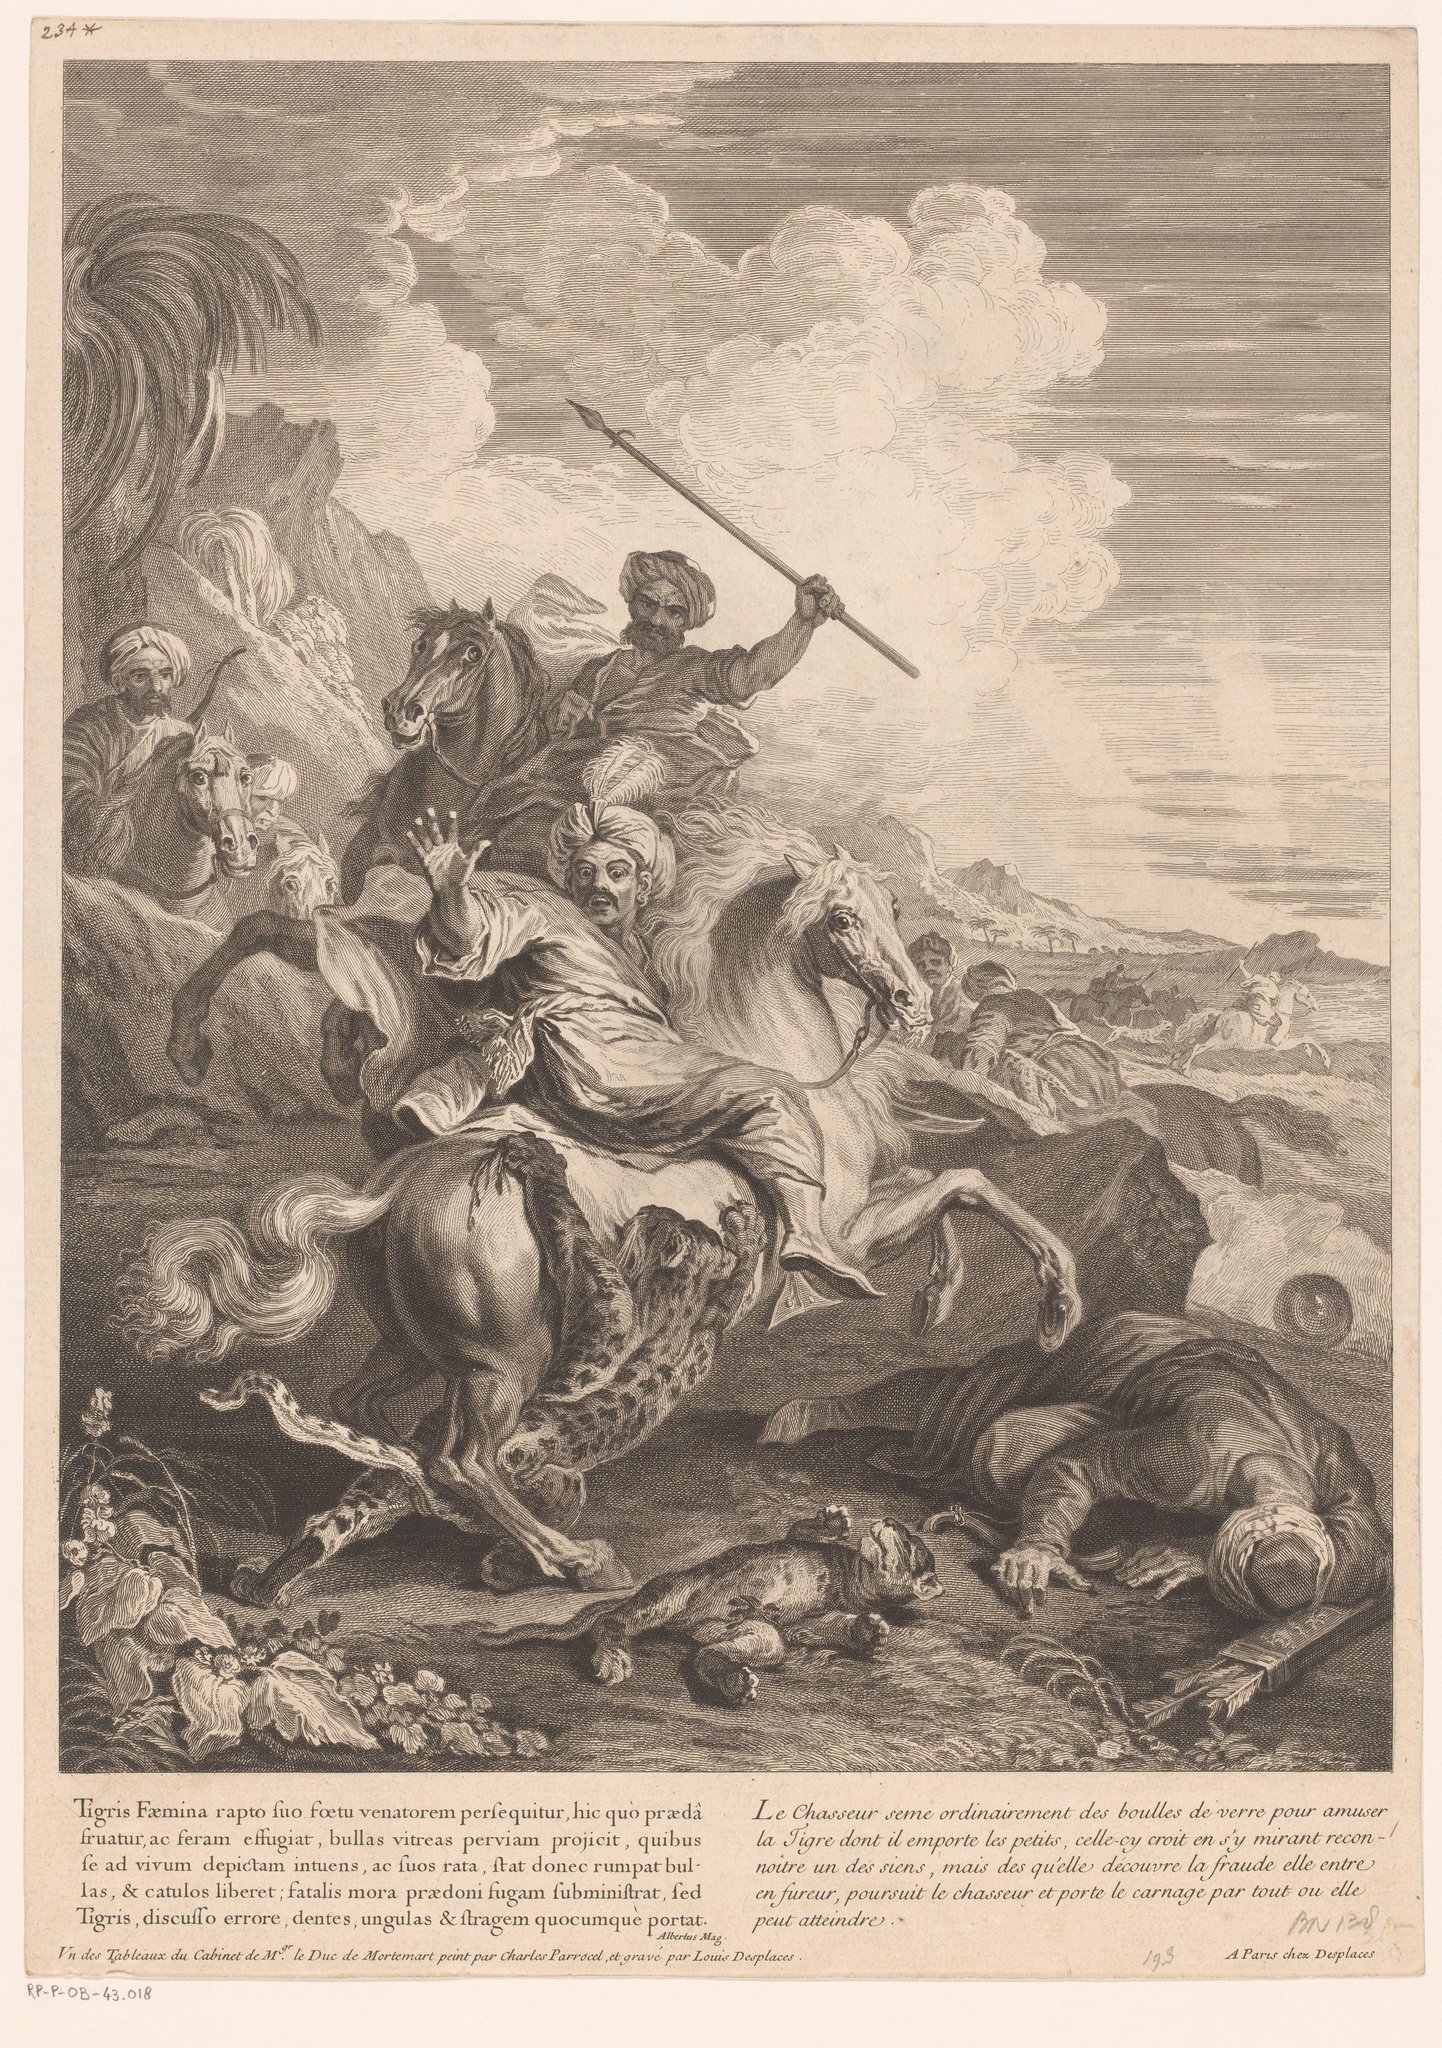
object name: print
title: Luipaardjacht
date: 1731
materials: paper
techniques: engraving, etching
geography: paris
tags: beasts of prey, predatory animals: leopard, hunt ~ predatory animals (fox, lion)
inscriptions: number: ‘23A*’, collector's mark: Lugt 240